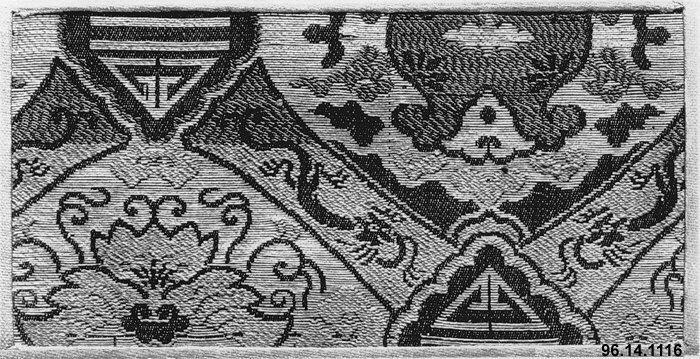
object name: piece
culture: japanese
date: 1701-1900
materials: silk